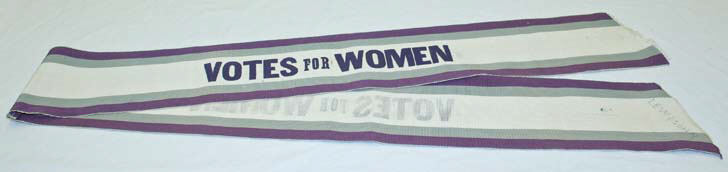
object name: ribbon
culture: american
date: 1890-1920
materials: silk